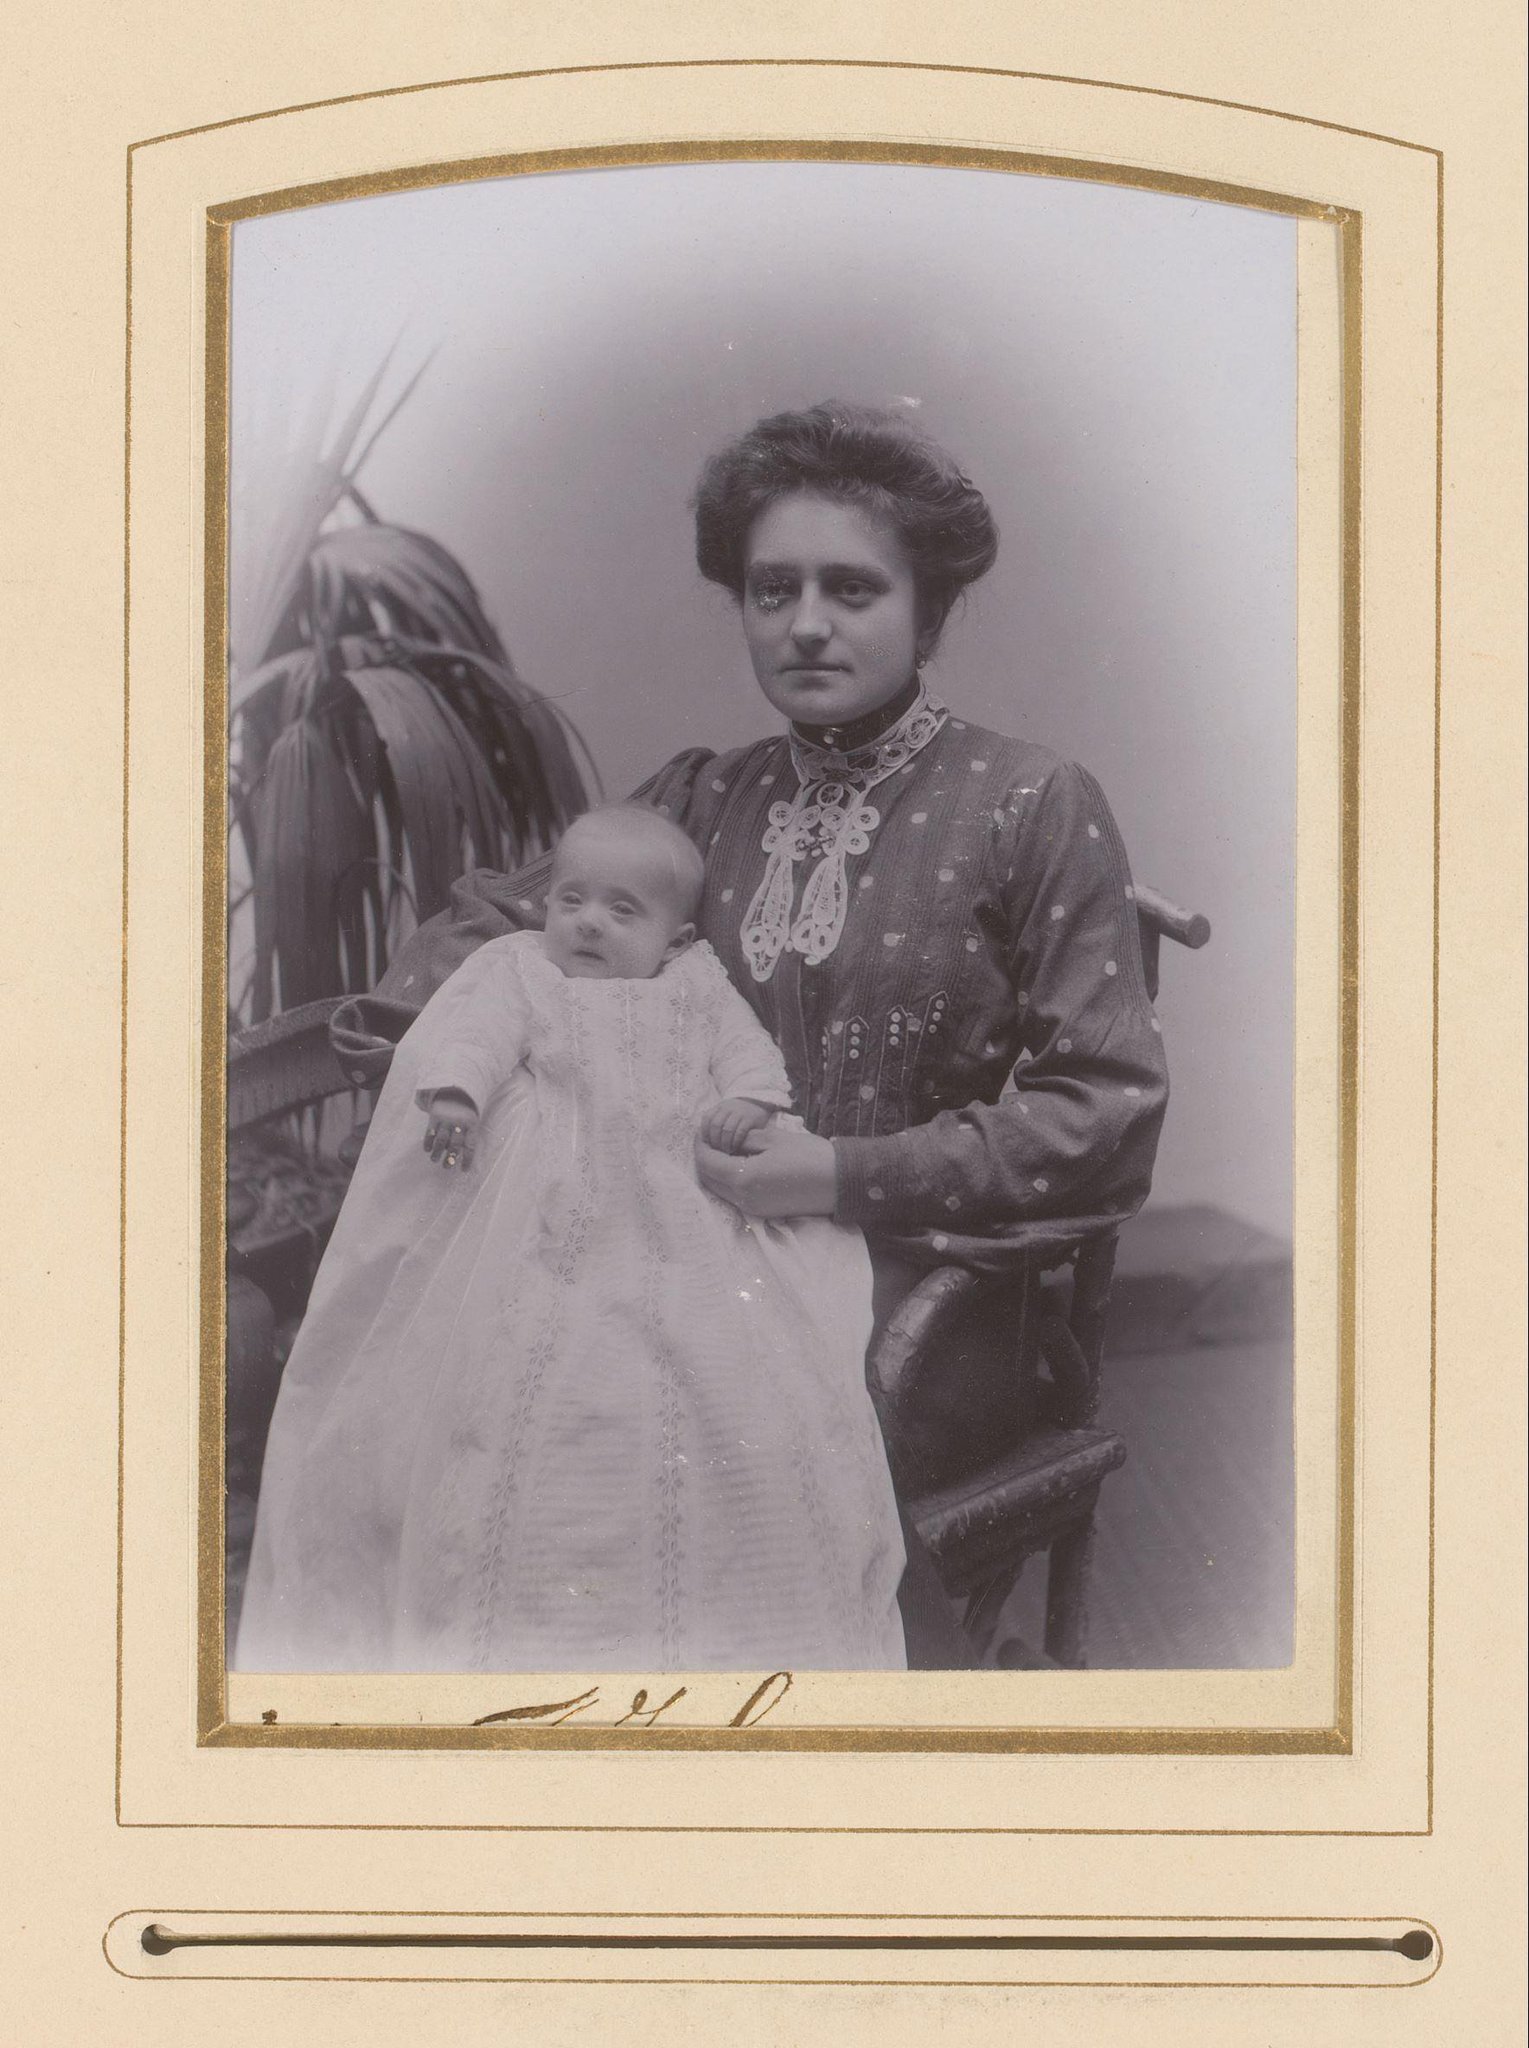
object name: photograph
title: Portret van een vrouw met een baby in doopjurk op schoot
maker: fr. john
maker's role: fotograaf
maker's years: 1849-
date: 1880-1920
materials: cardboard, photographic support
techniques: collodion silver print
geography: antwerp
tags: historical persons - bb - woman, infant, baby ~ the ages of man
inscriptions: inscription: ‘Photographie/ Artistique/ Fr. John/ Anvers/ Canal des Brasseurs/ 54/ Spécialité/ d'Agrandissements/ au CHARBON et/ au PLATINE/ Les clichés sont conservés./ de Platen worden bewaard.’